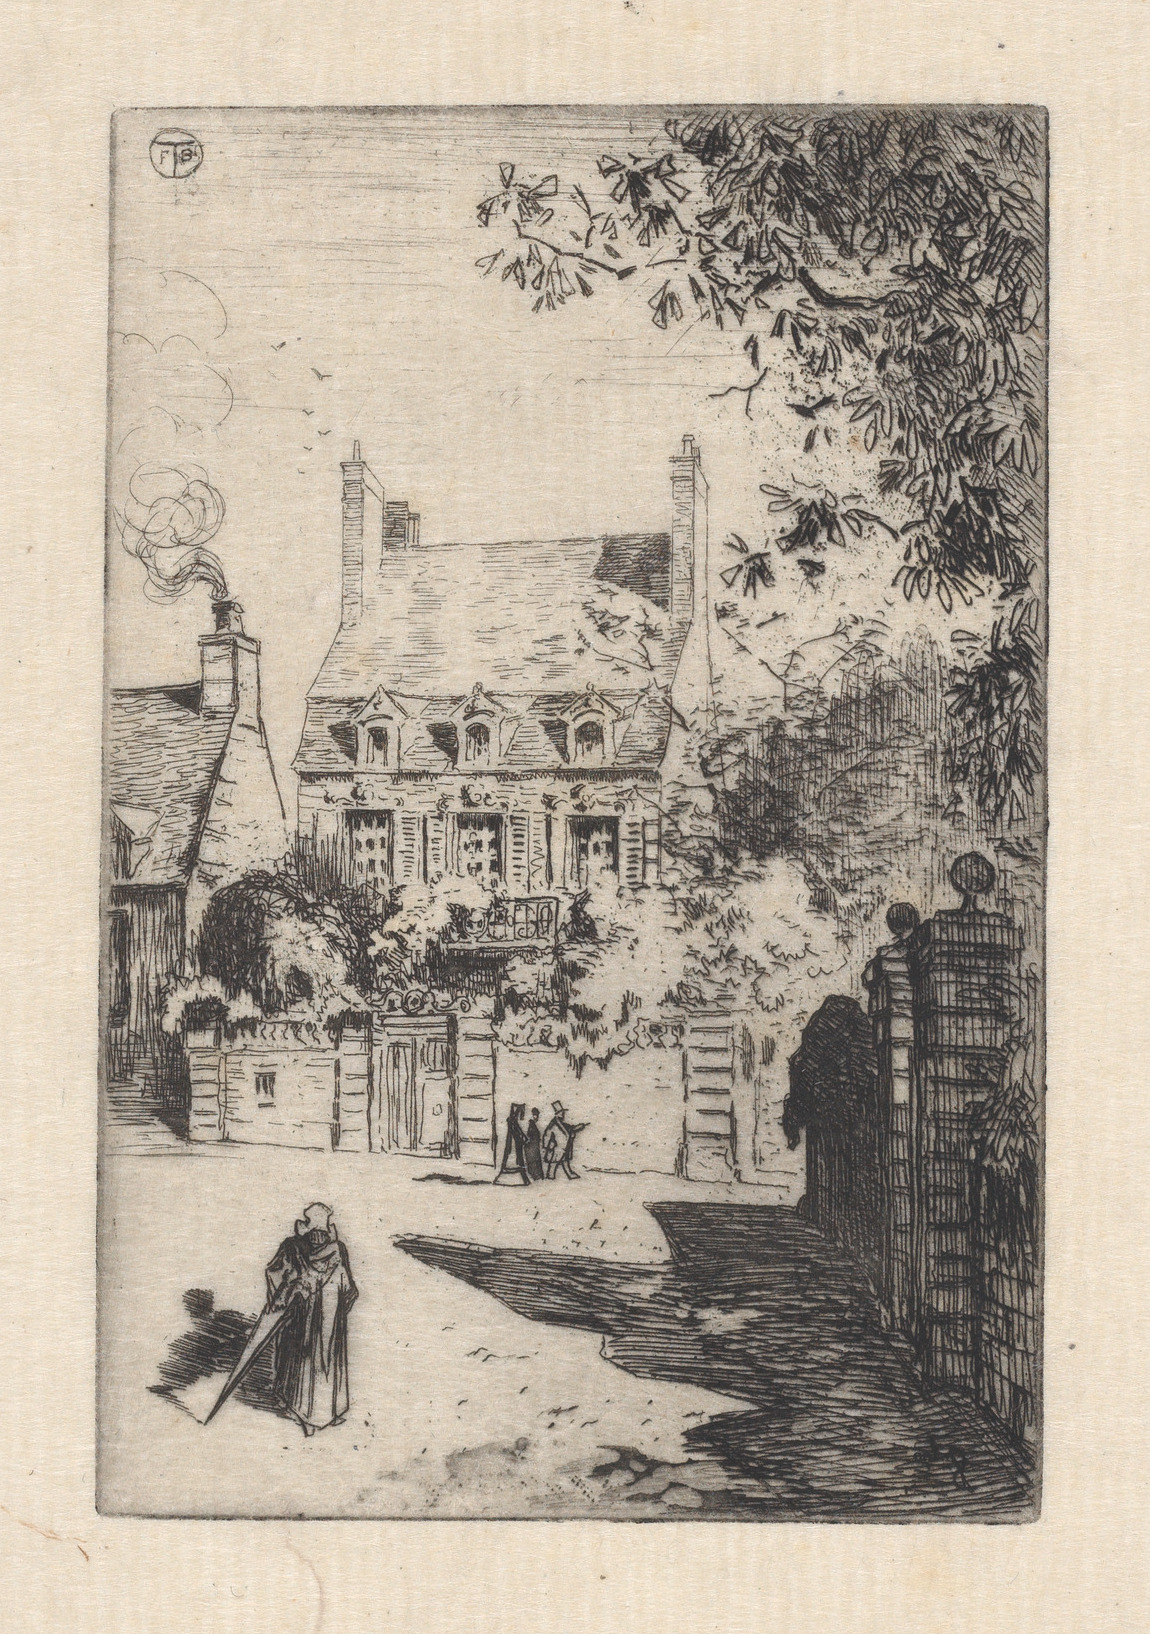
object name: print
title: In the Provinces -- The House of Orléans (Valognes)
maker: félix-hilaire buhot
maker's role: artist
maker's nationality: french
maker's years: 1847-1898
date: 1860-1898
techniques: aquatint, etching